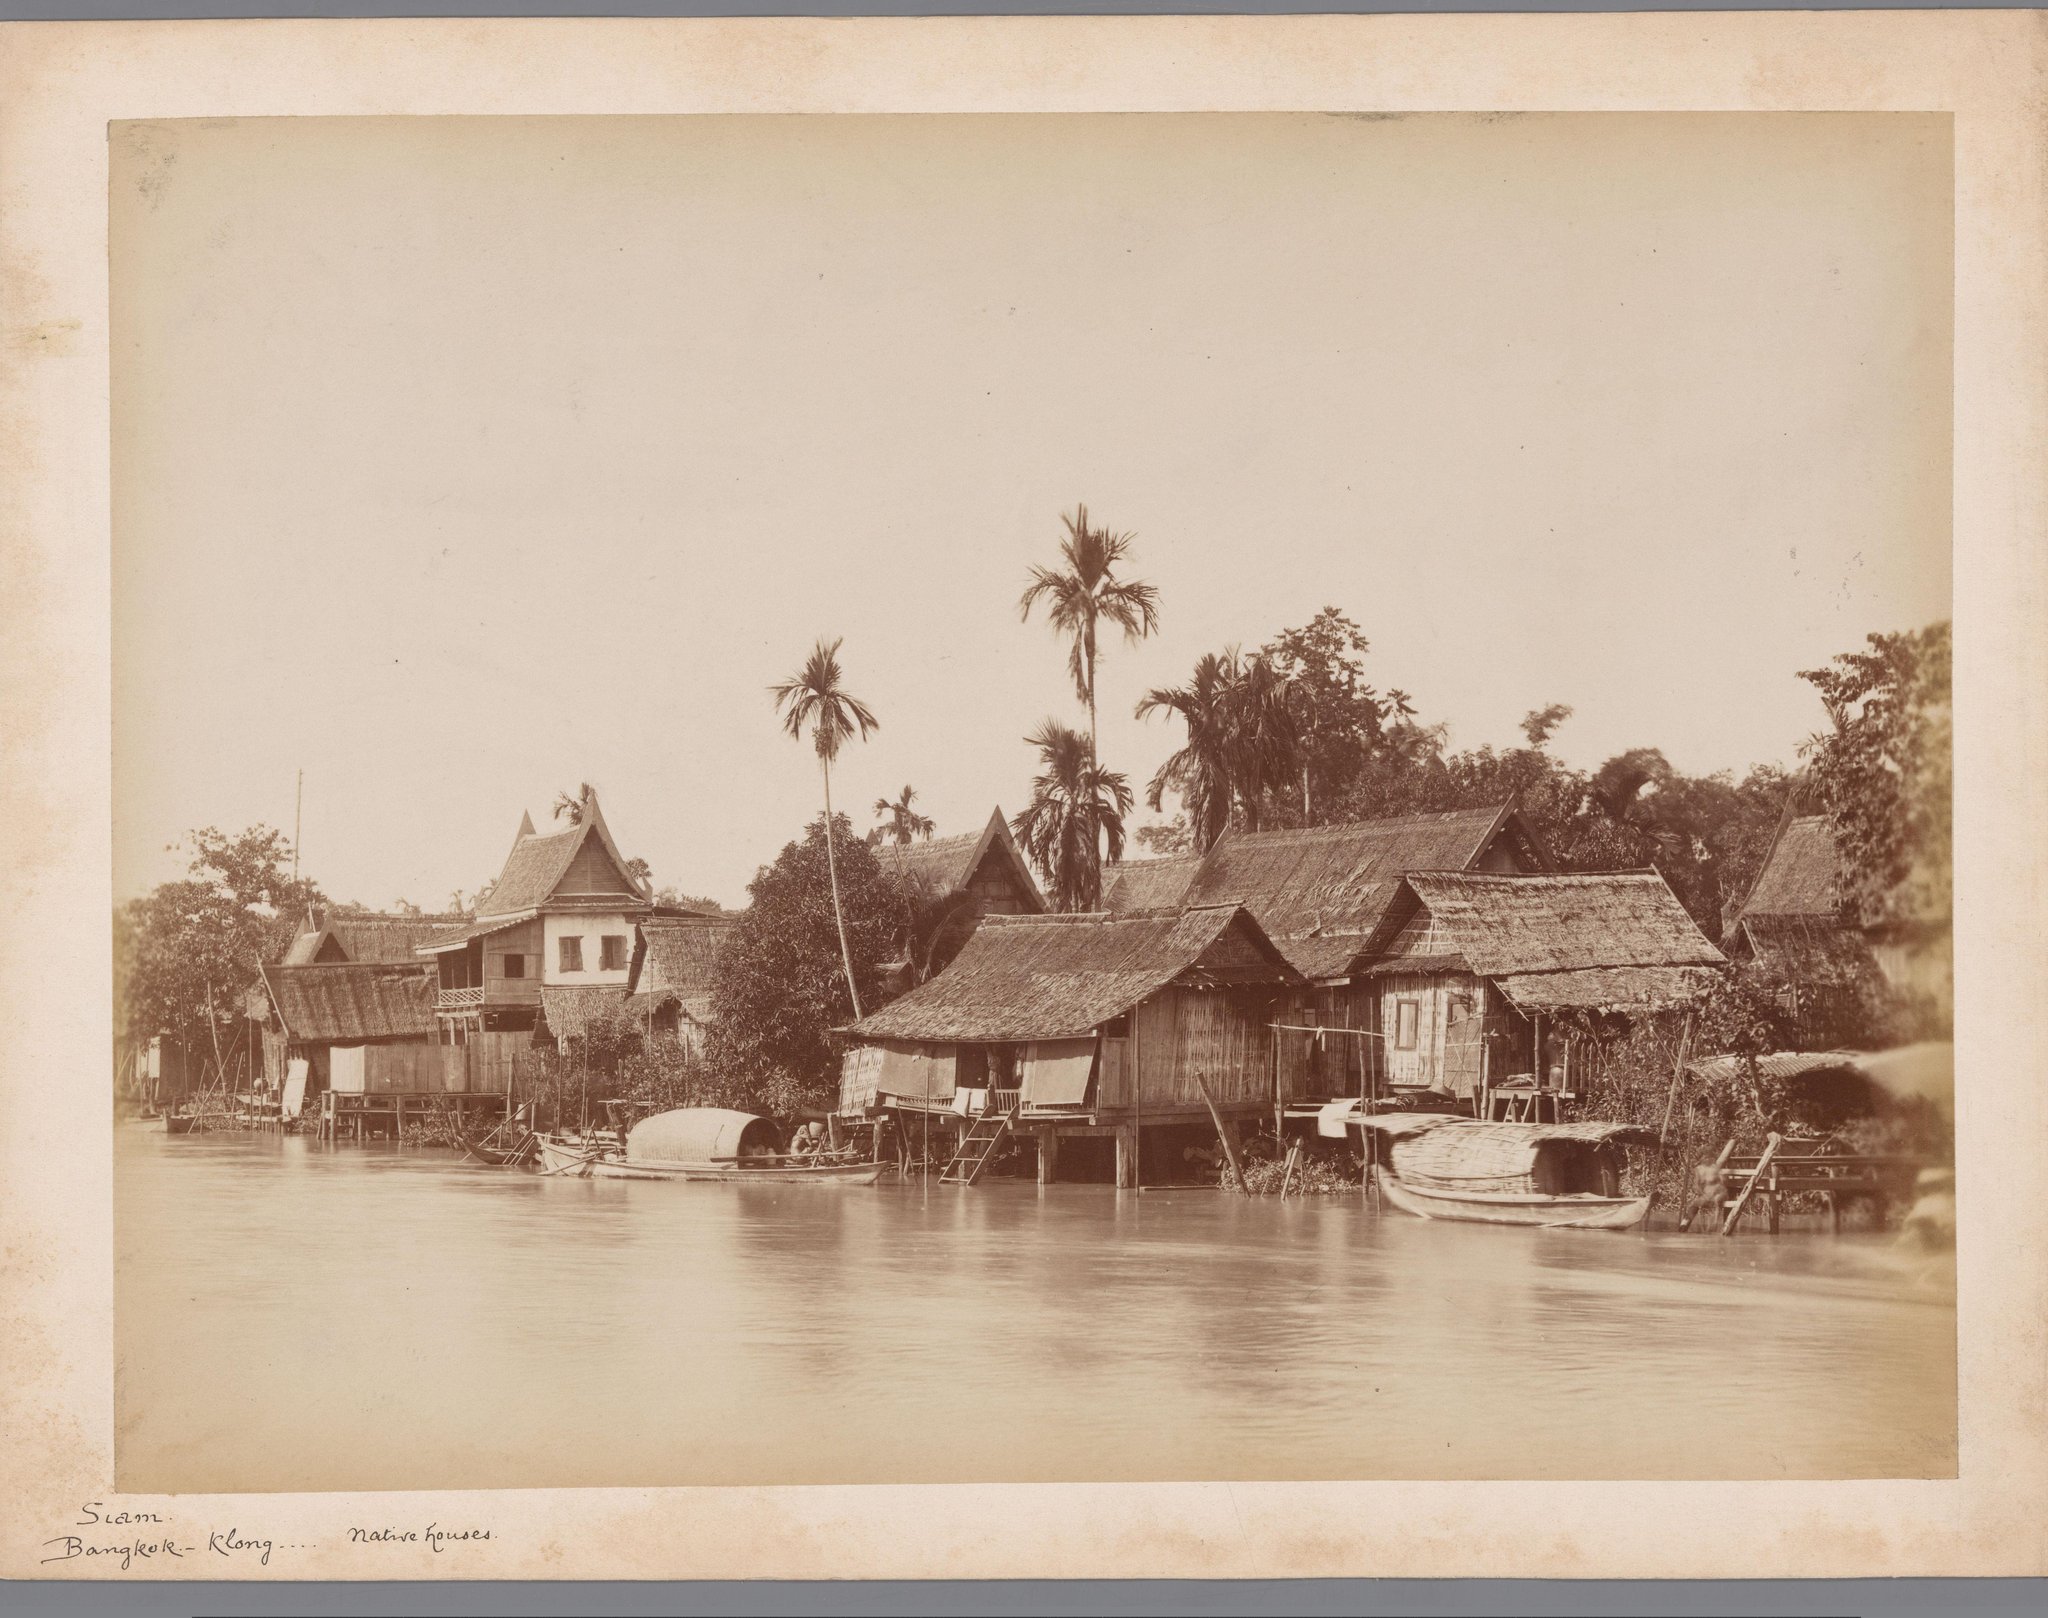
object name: photograph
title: Siam, Bangkok-Klong, native houses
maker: Anonymous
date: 1860-1900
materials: cardboard, paper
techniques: albumen print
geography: bangkok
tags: canals, waters (in city)